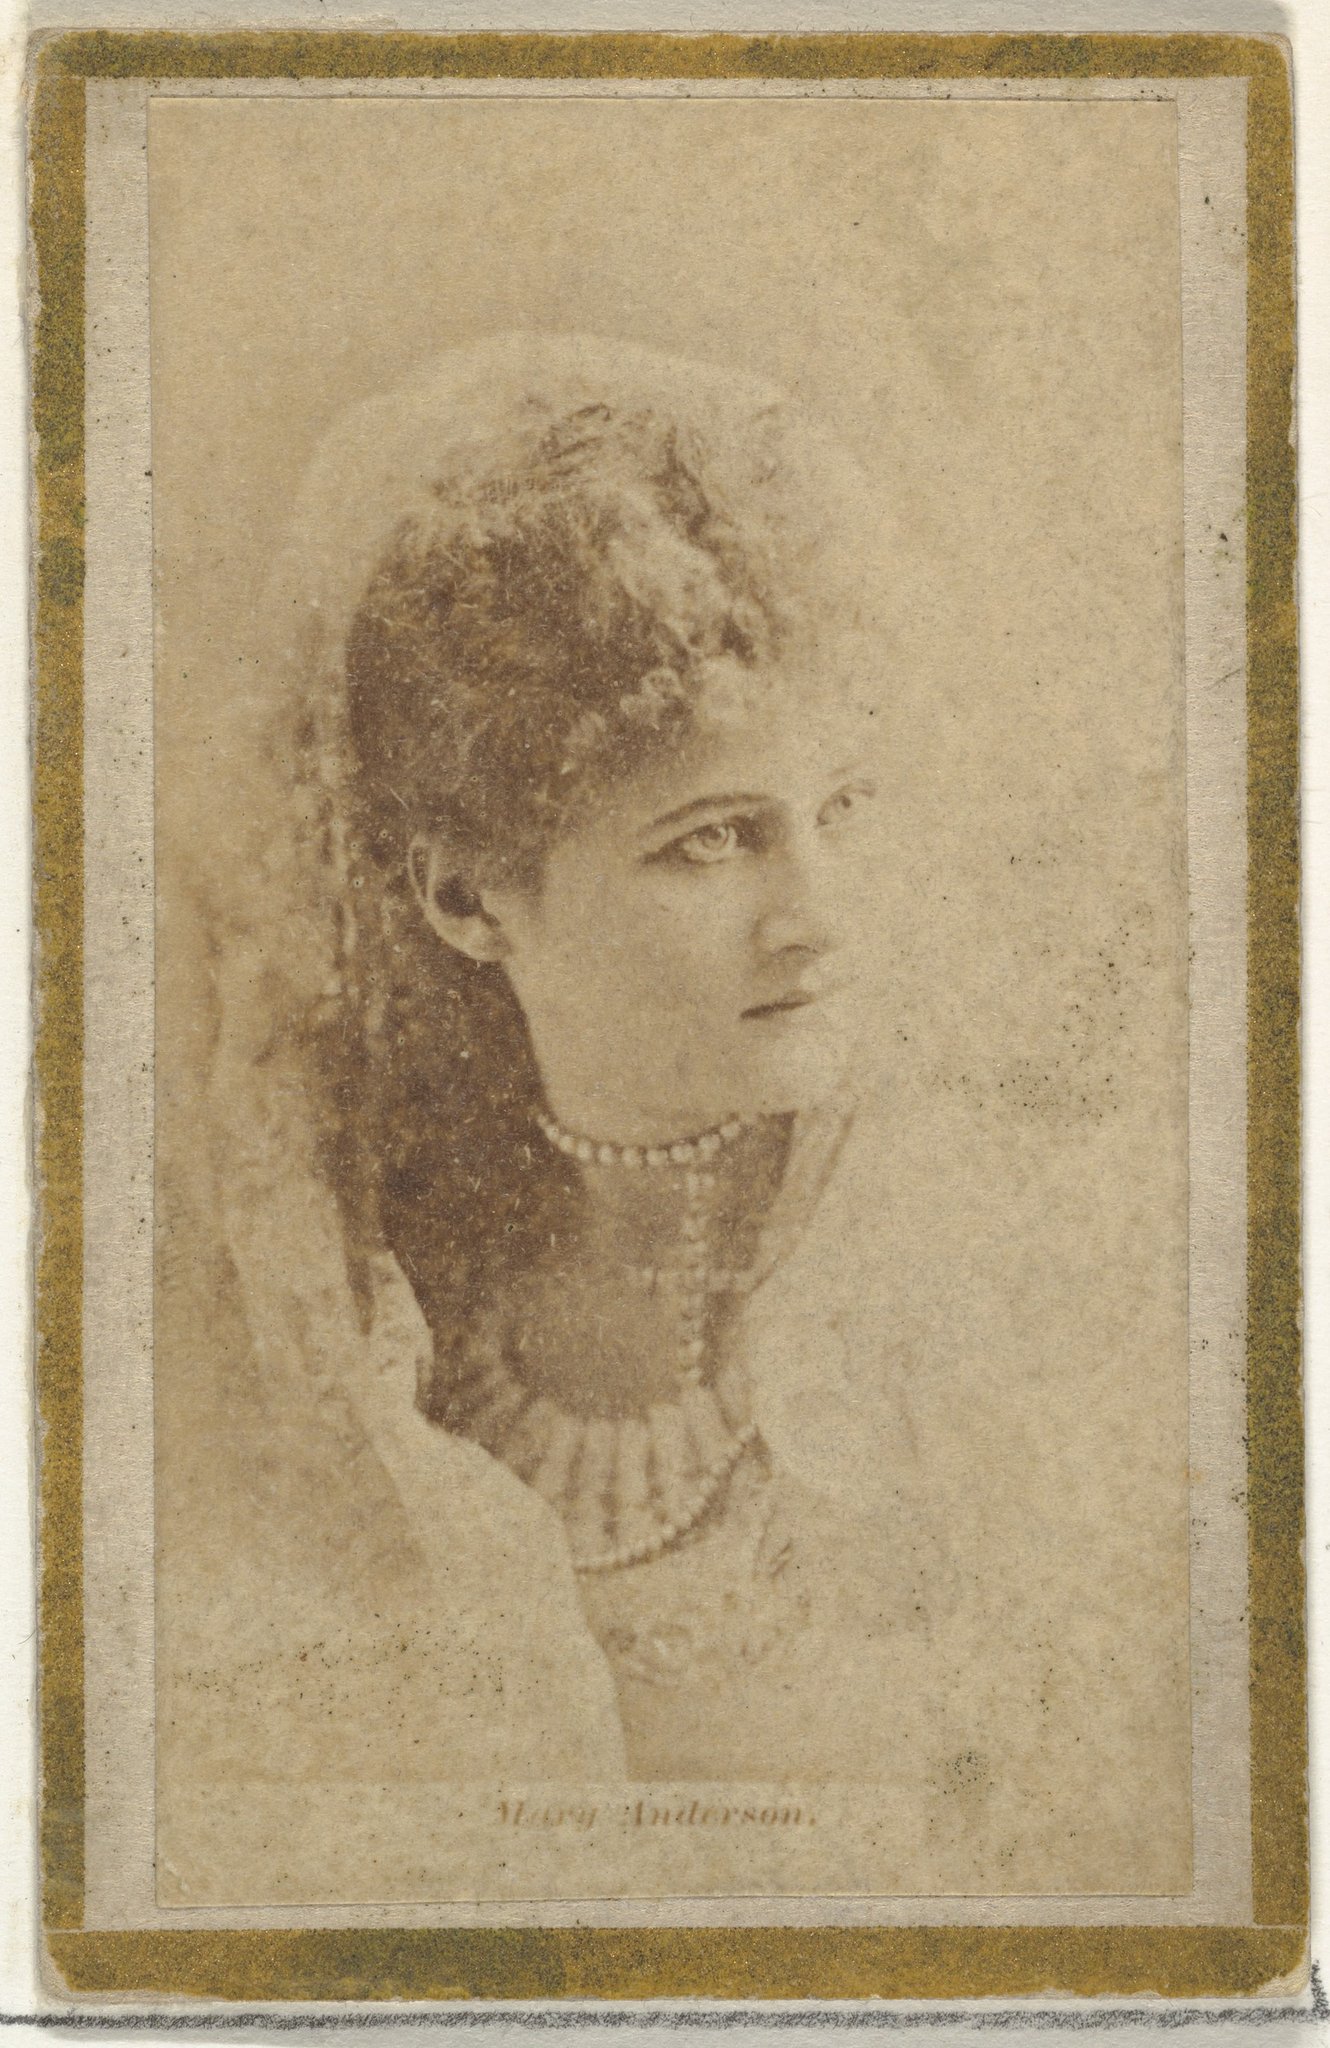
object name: photograph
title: Mary Anderson, from the Actresses and Celebrities series (N60, Type 2) promoting Little Beauties Cigarettes for Allen & Ginter brand tobacco products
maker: allen & ginter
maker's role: publisher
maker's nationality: american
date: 1887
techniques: albumen silver print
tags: portraits,women,actresses